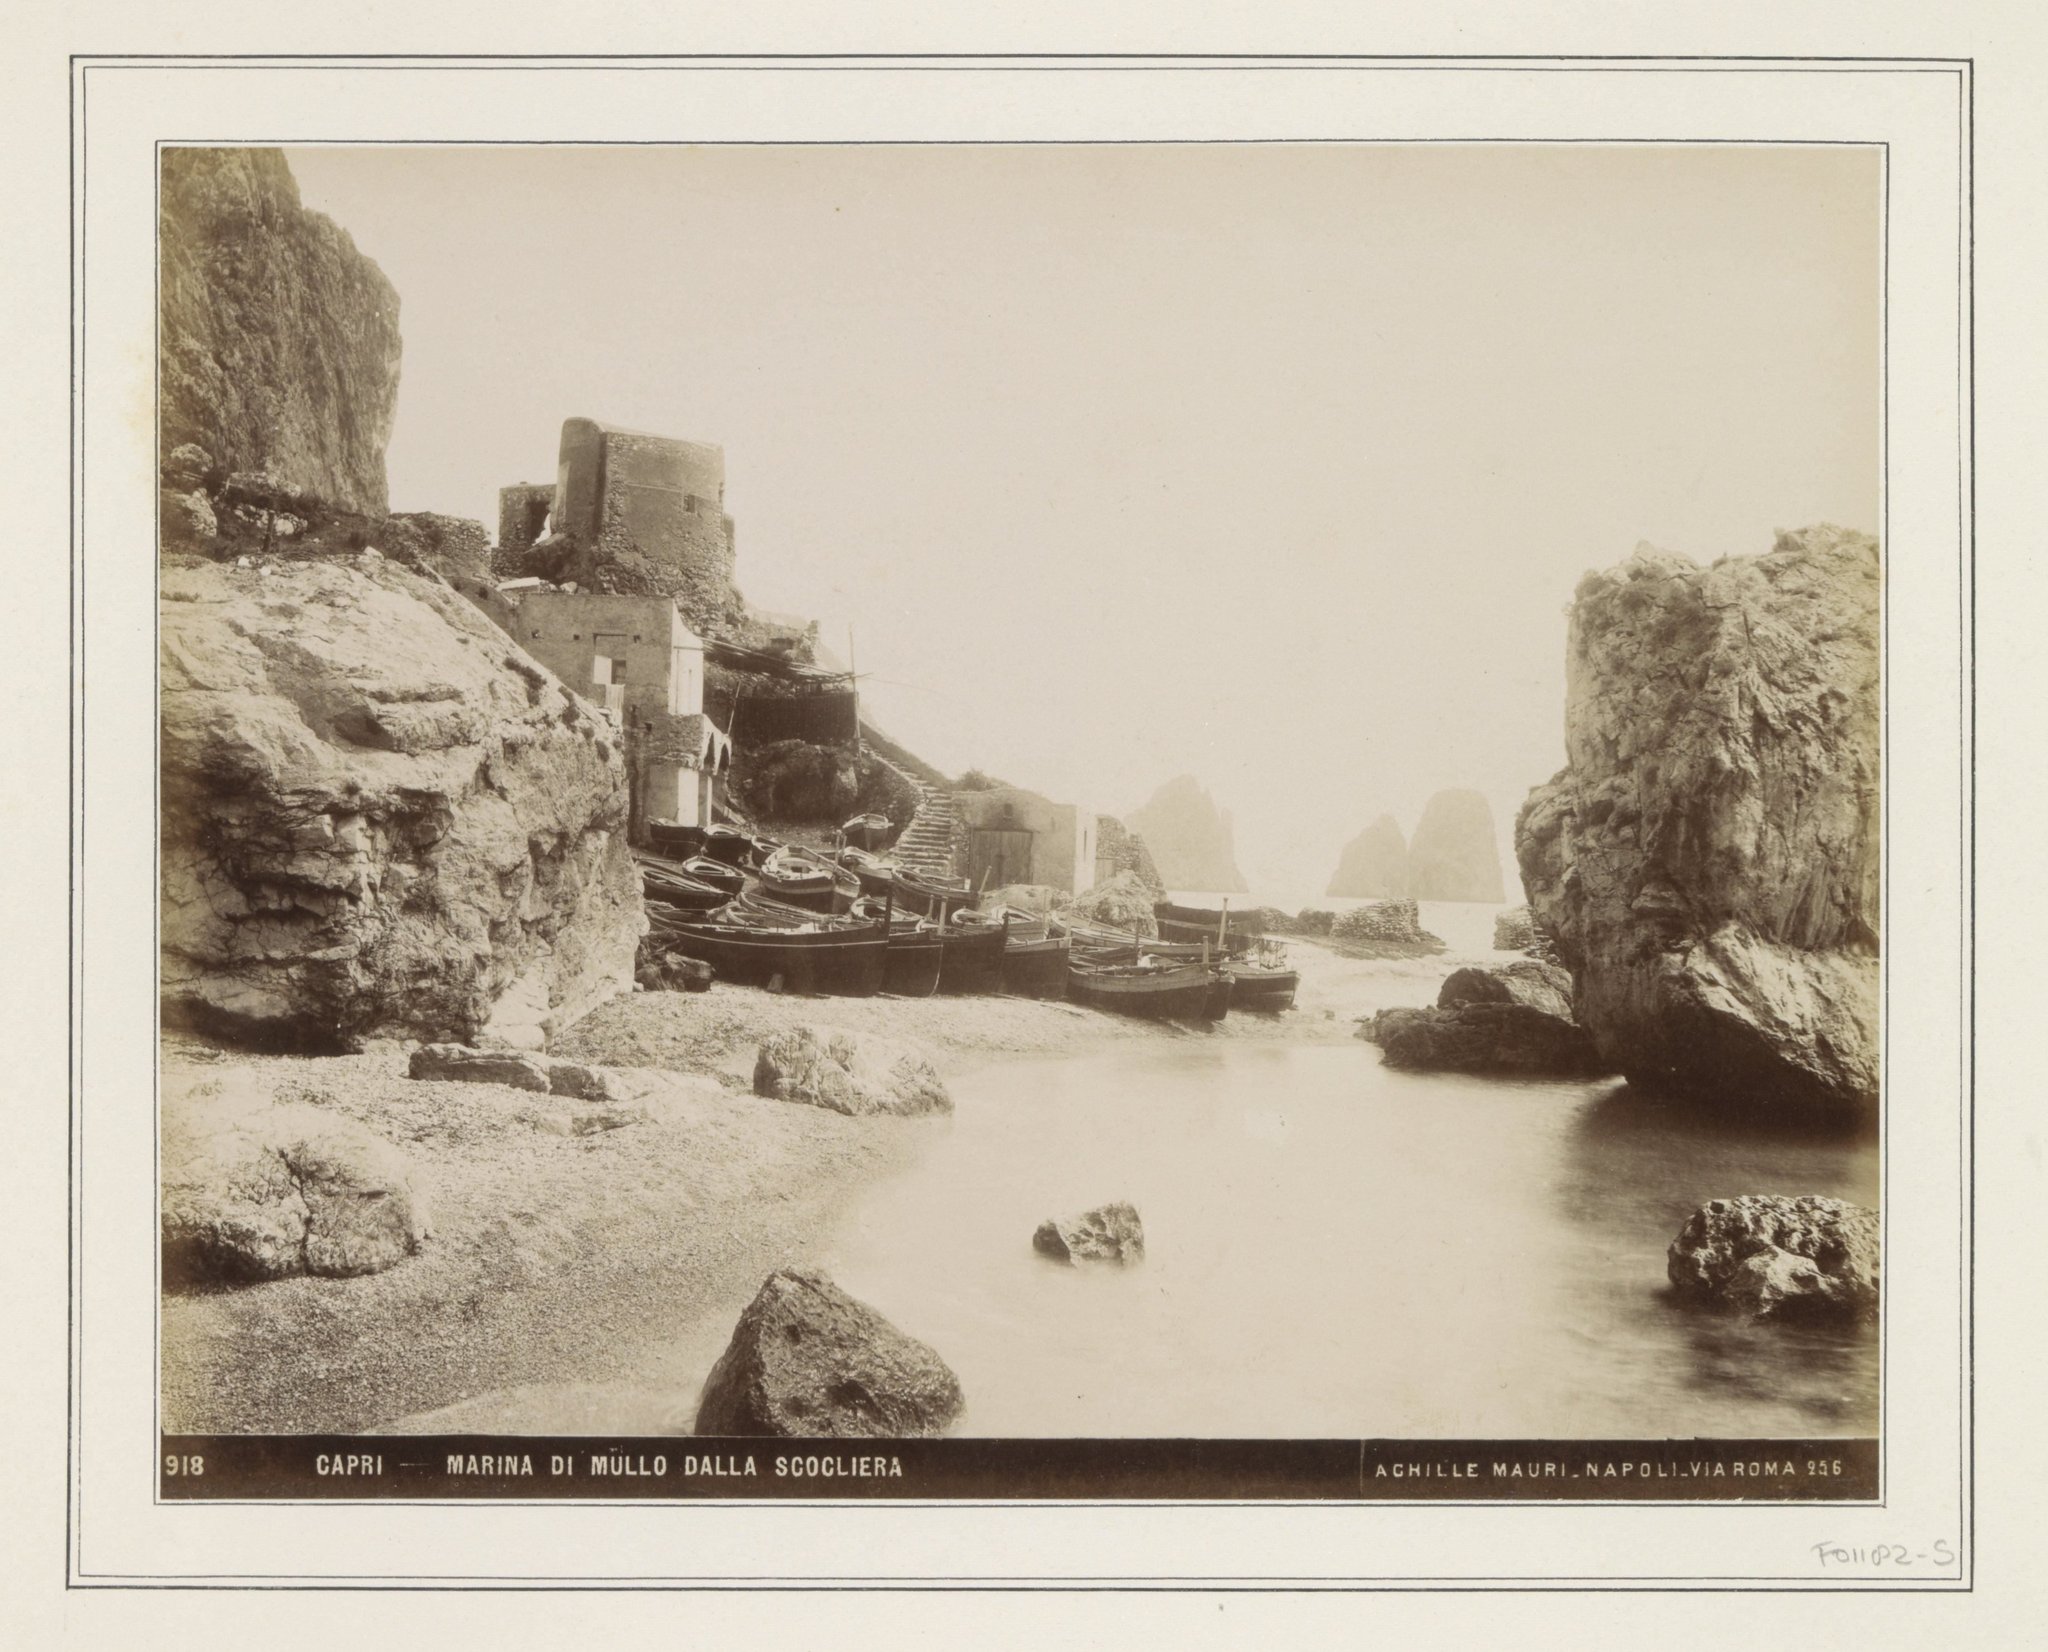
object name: photograph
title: Gezicht op Marina di Mulo op Capri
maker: achille mauri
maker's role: fotograaf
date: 1860-1890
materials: paper, photographic support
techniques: albumen print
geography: capri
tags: prospect of village, silhouette of village, harbour (+ view ~ vehicle, ship, etc.), capri, isola di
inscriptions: negative number: ‘918’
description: Onderdeel van Reisalbum met foto's van bezienswaardigheden in Italië en aan de Franse Rivièra (deel II).